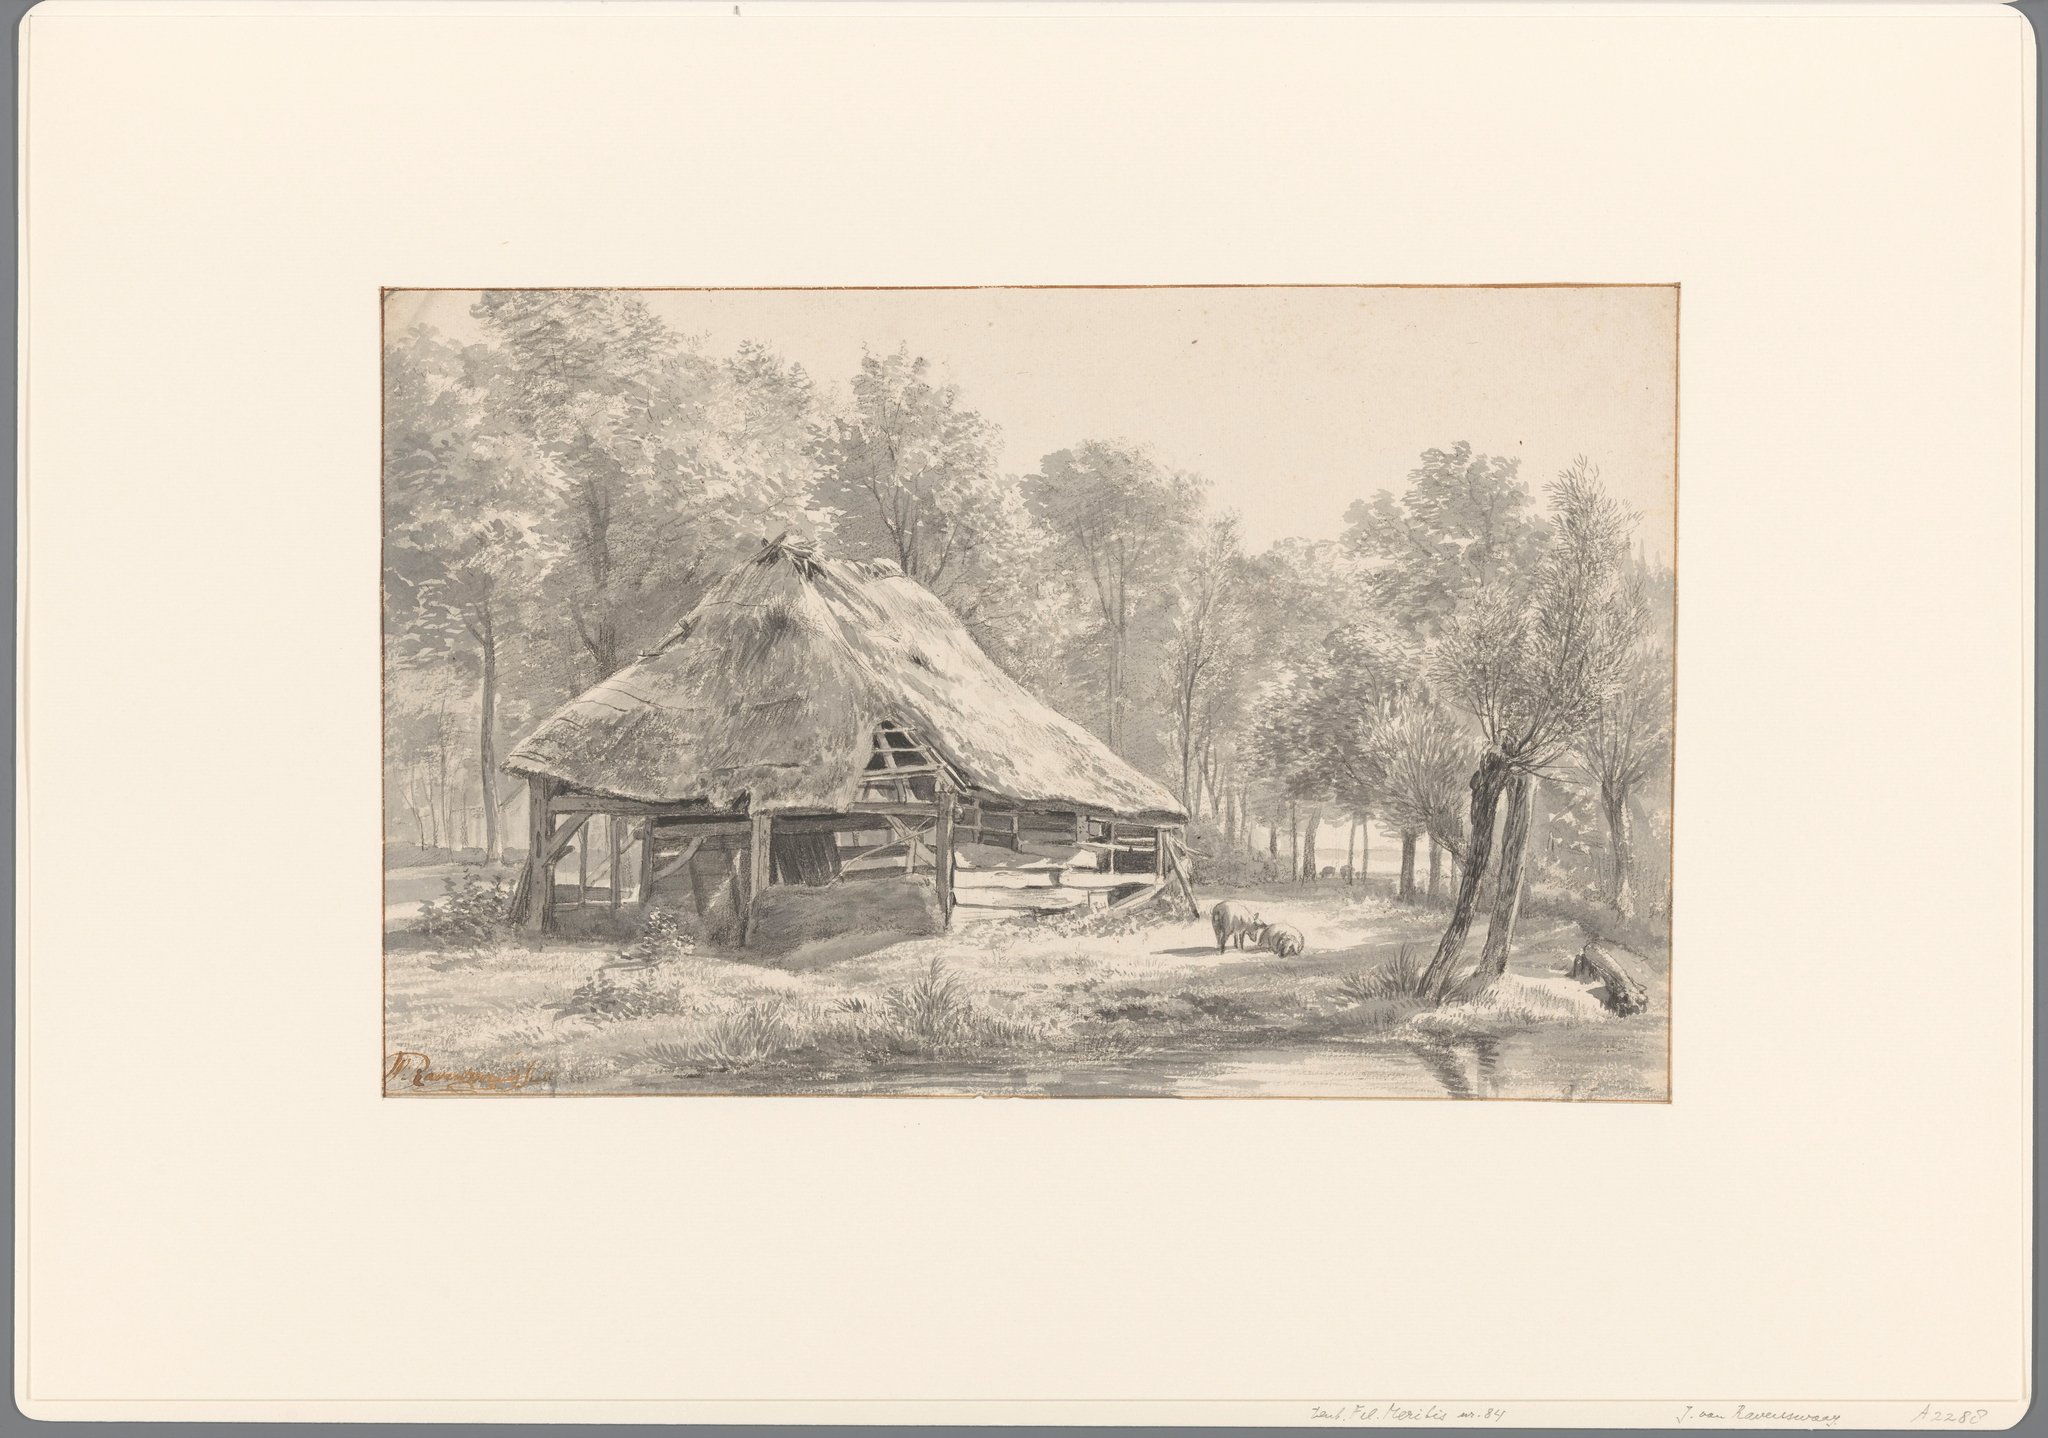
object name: drawing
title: Vervallen boerenschuur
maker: jan van ravenswaay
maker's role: draughtsman, painter, print maker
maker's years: 1789-1869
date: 1799-1869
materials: chalk, paper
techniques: brush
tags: barn